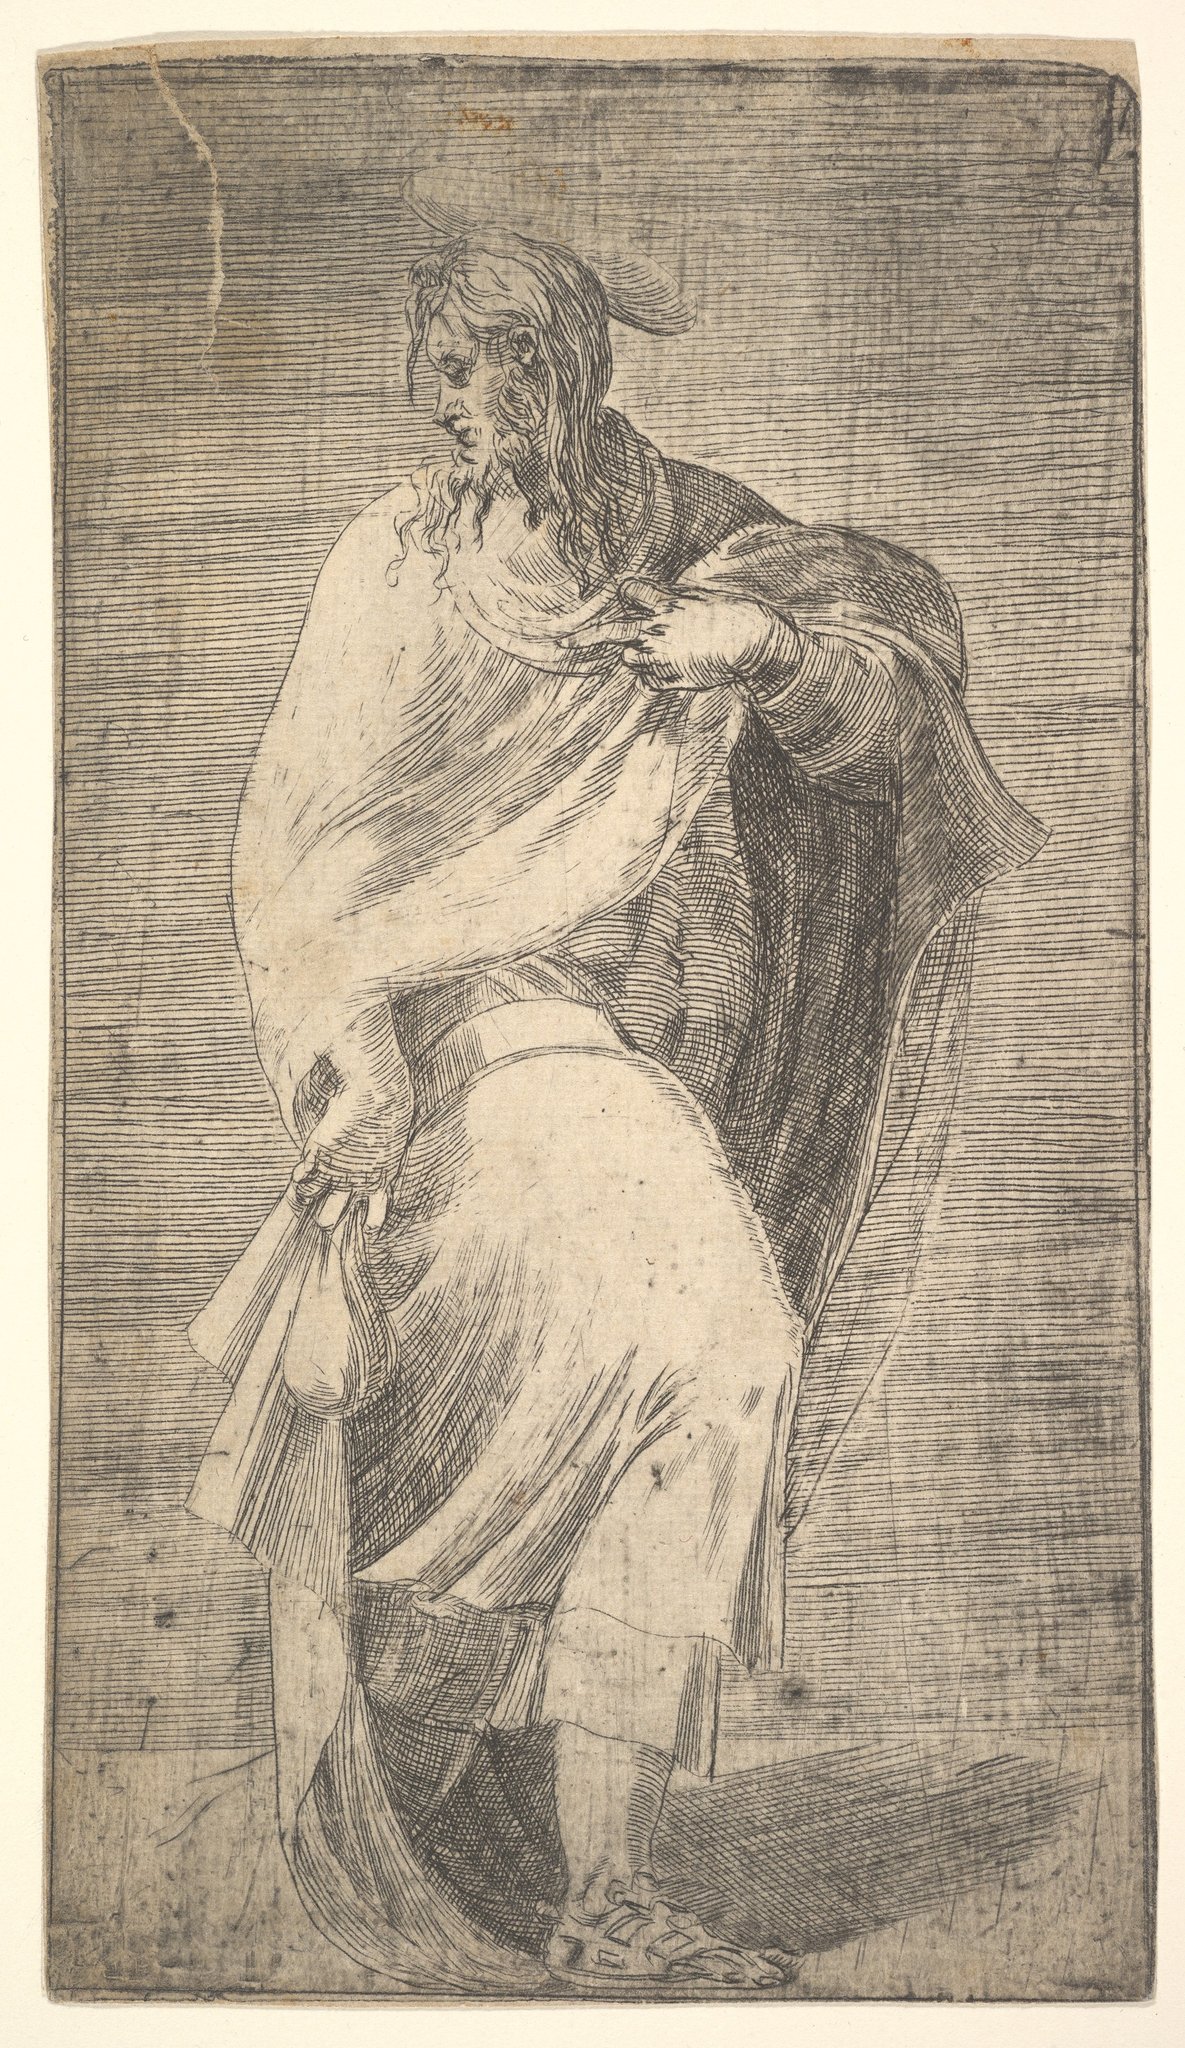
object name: print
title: Saint Matthew, from "Christ and the Apostles"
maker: andrea schiavone (andrea meldola)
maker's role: artist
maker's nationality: italian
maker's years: 1510-1563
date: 1548-1550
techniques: etching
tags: saint matthew